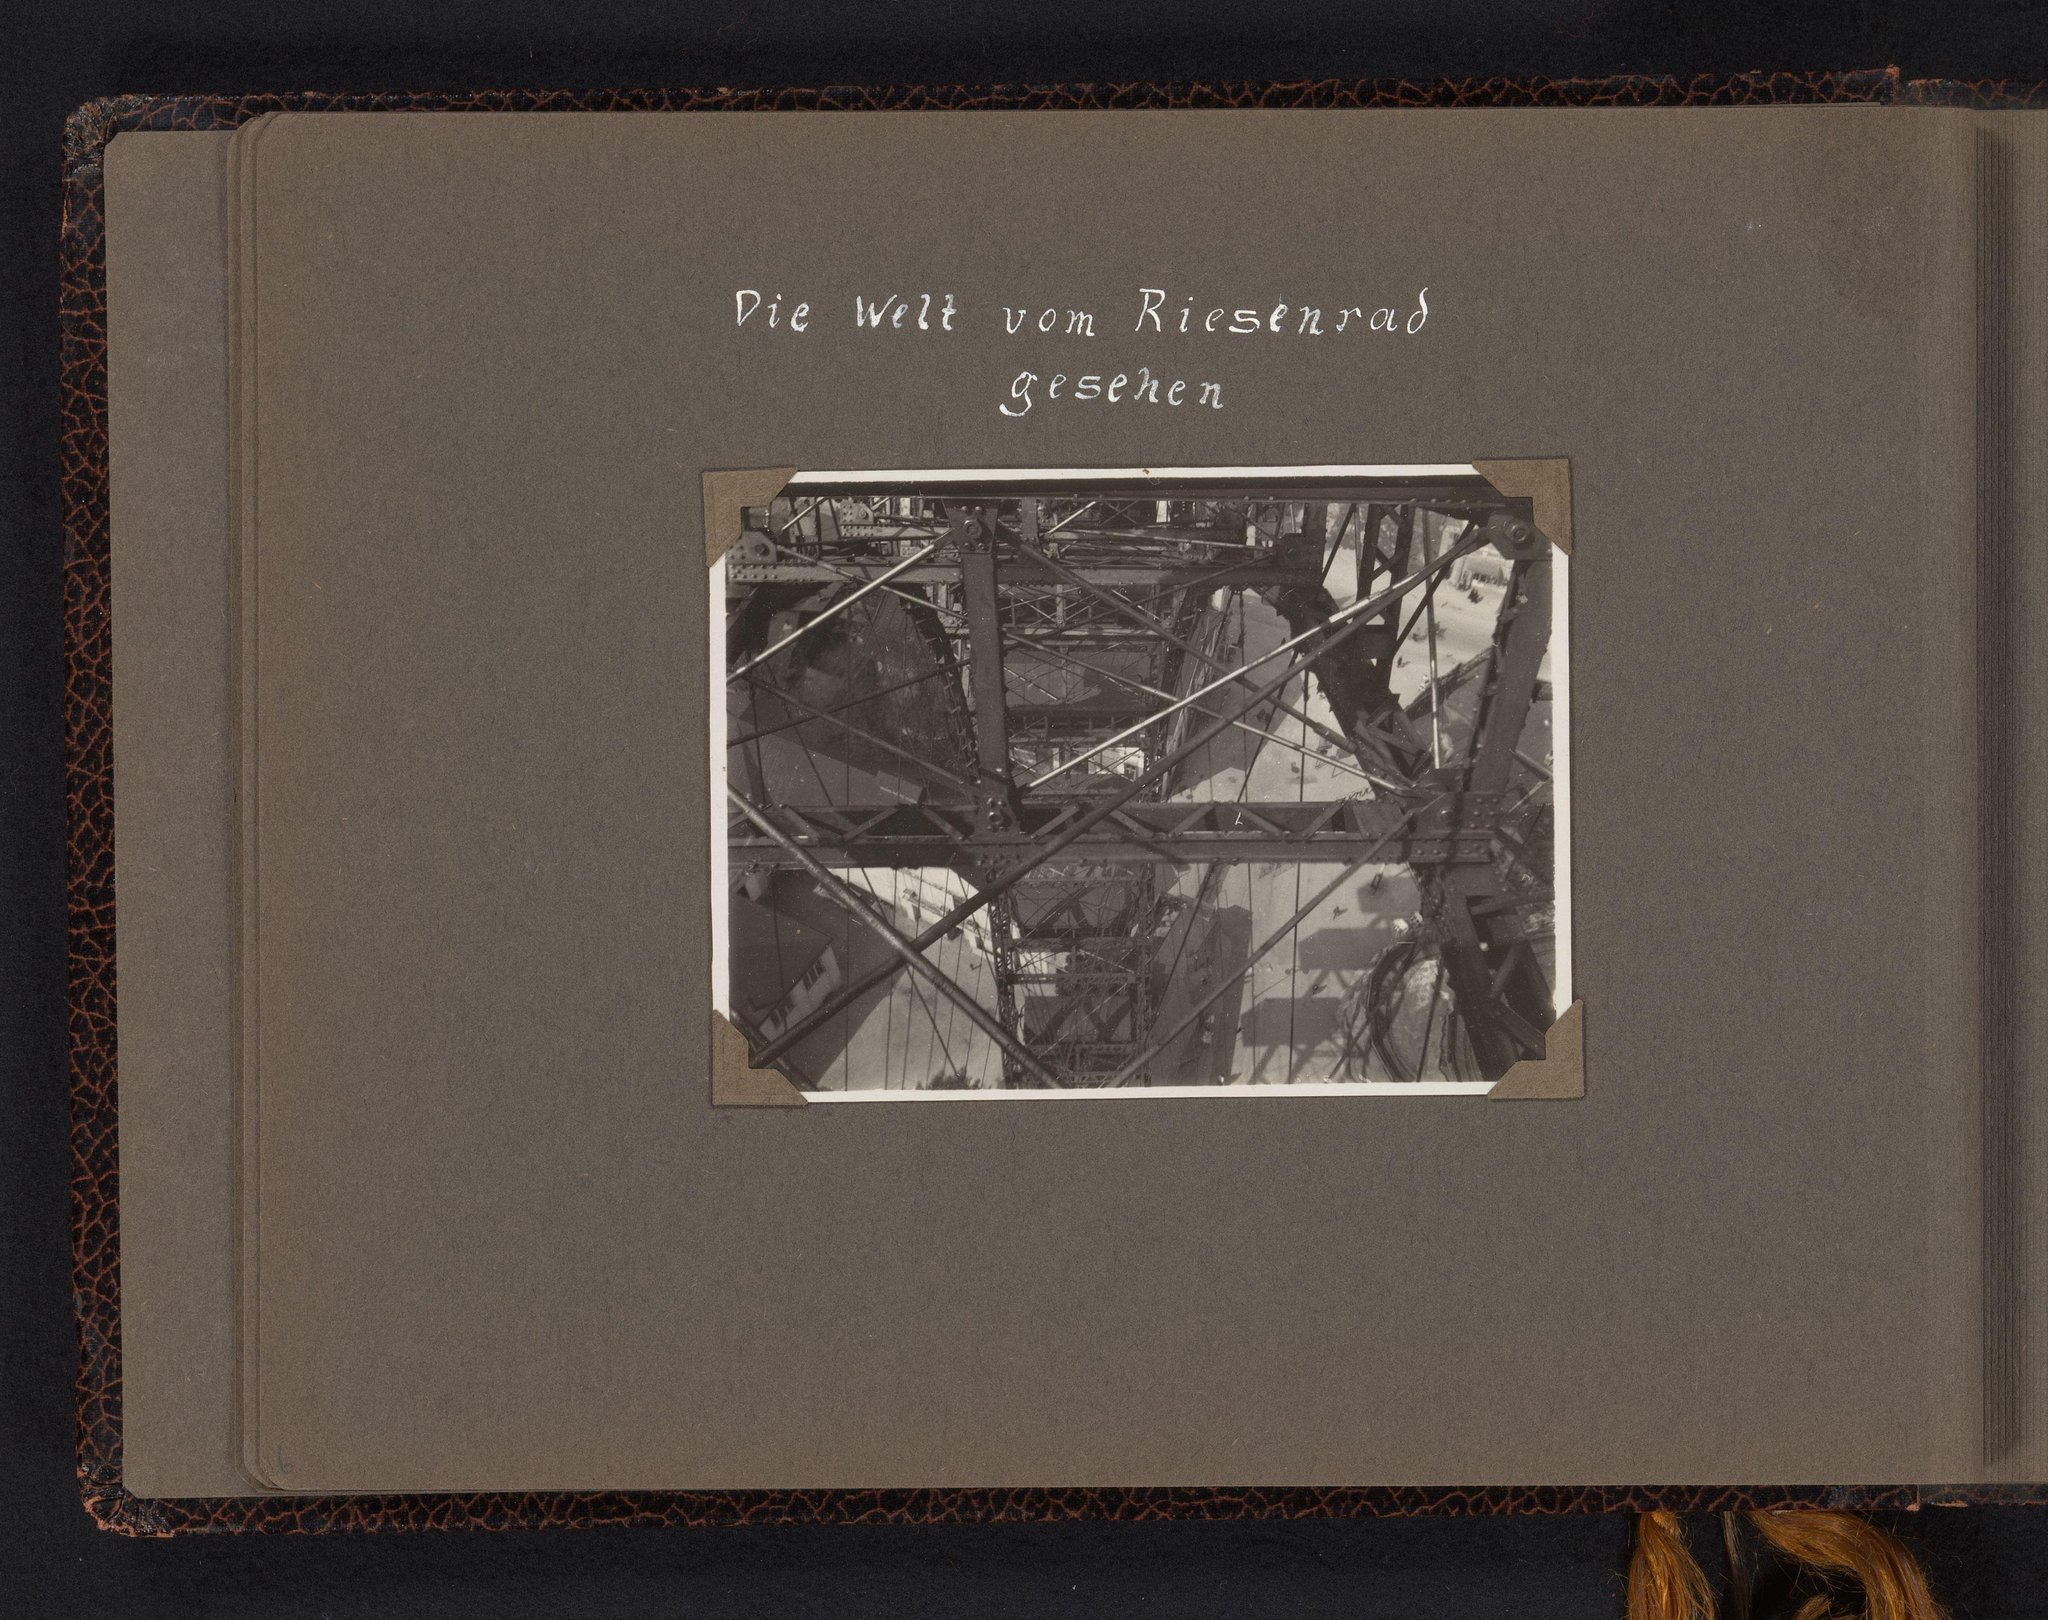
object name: photograph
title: Uitzicht vanuit het reuzenrad in het Prater te Wenen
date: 1930-1931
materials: cardboard, paper, photographic support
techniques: gelatin silver print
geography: vienna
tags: giant wheel, ferris wheel, vienna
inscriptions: annotation: ‘Die welt vom Riesenrad gesehen’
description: Deze pagina maakt deel uit van een album.